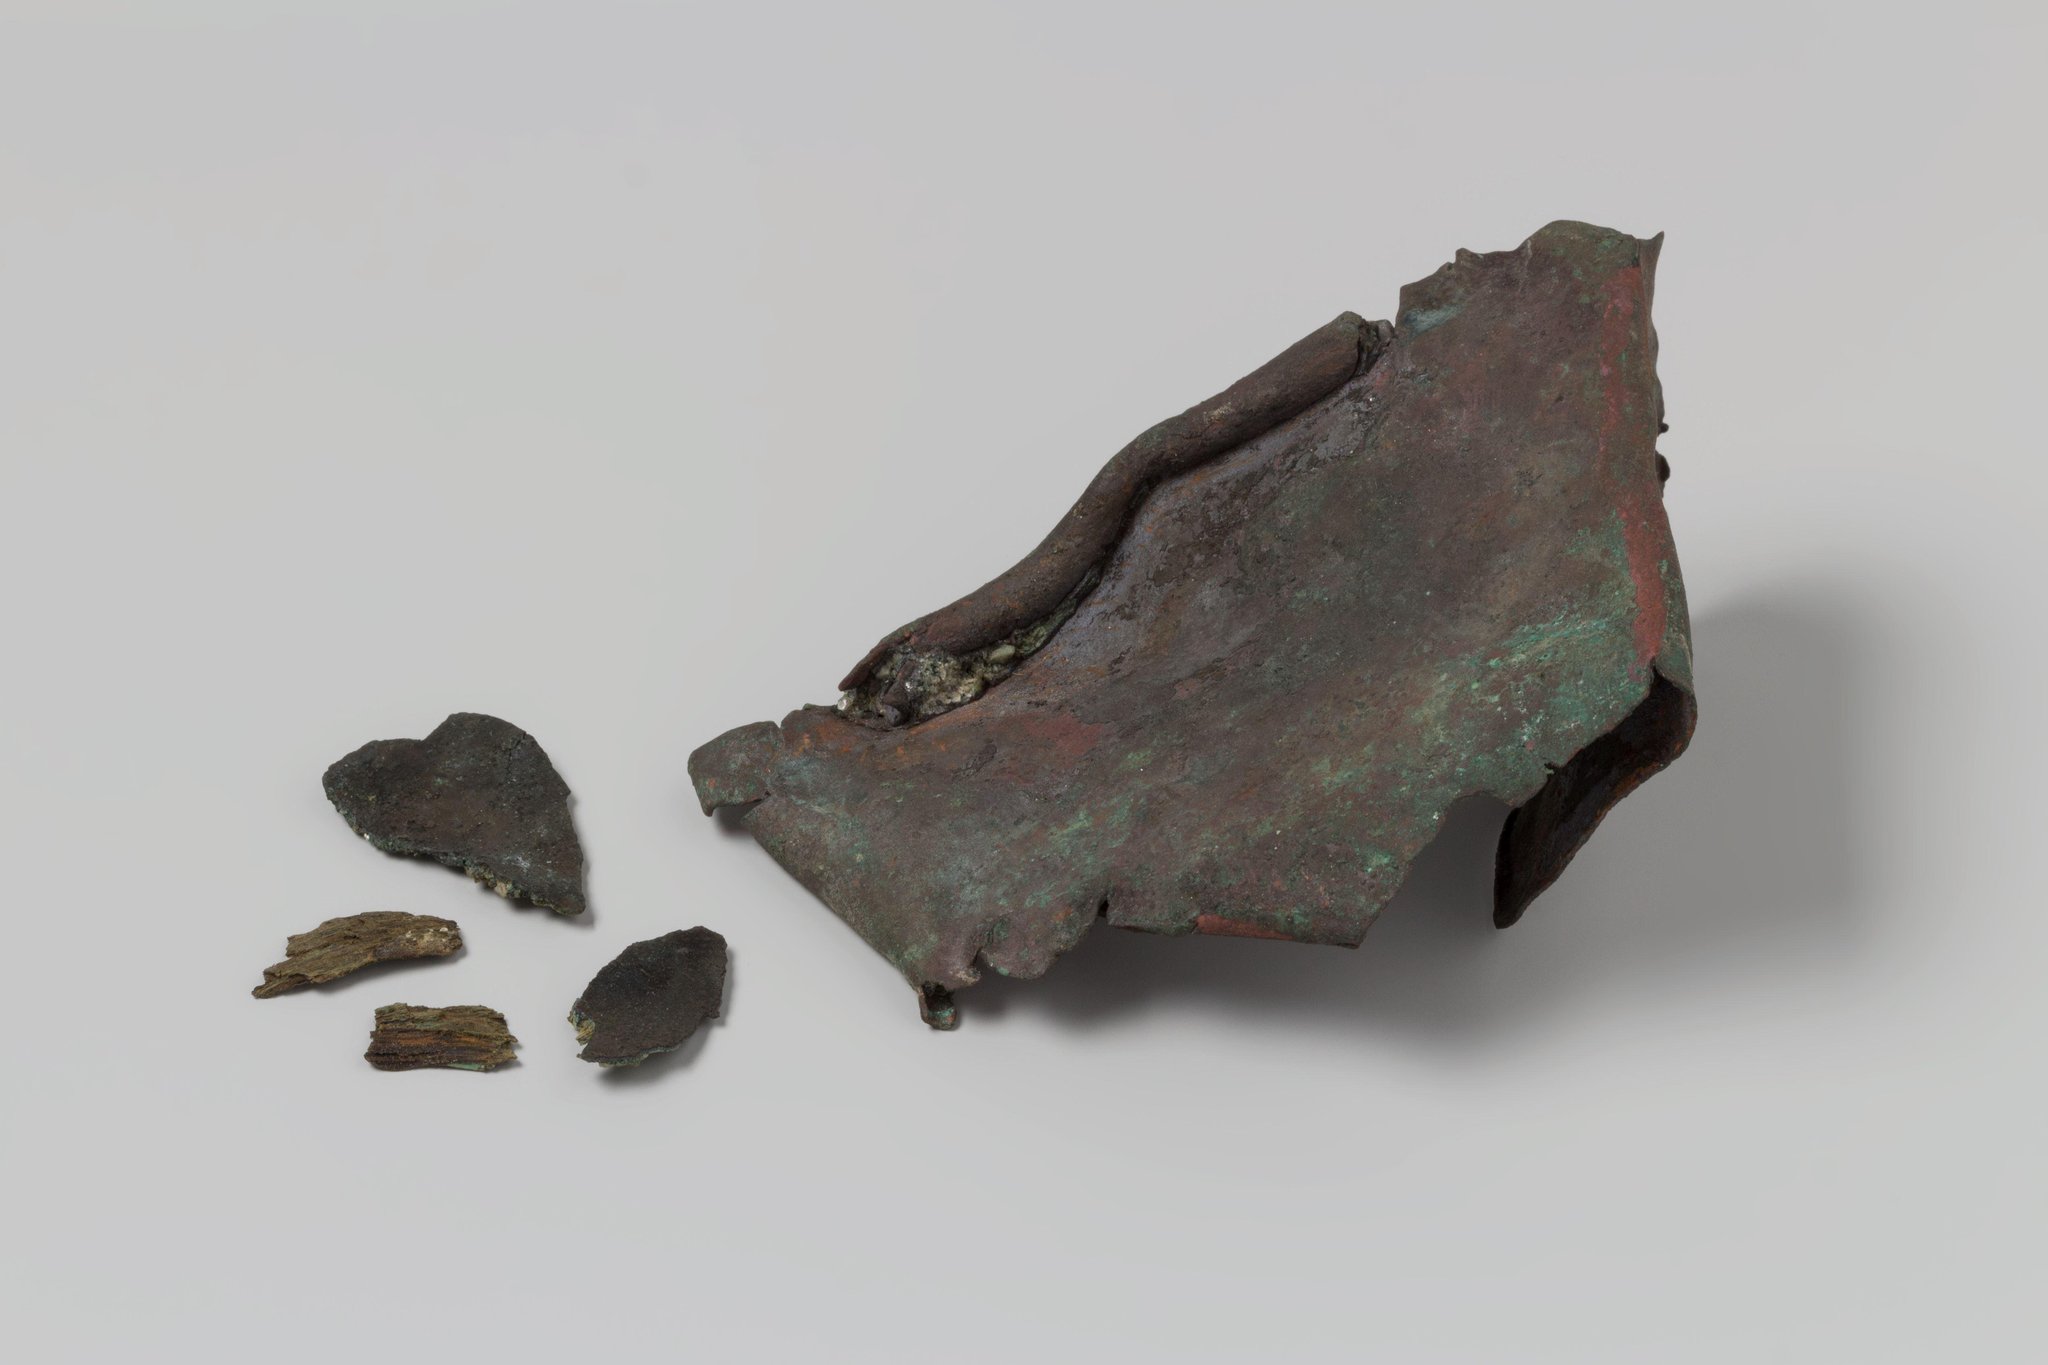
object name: scheepswrakvondst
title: Fragmenten van koper uit het wrak van de Oost-Indiëvaarder Hollandia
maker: Anonymous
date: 1700-1743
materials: copper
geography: netherlands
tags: verenigde oostindische compagnie, hollandia (schip), annet